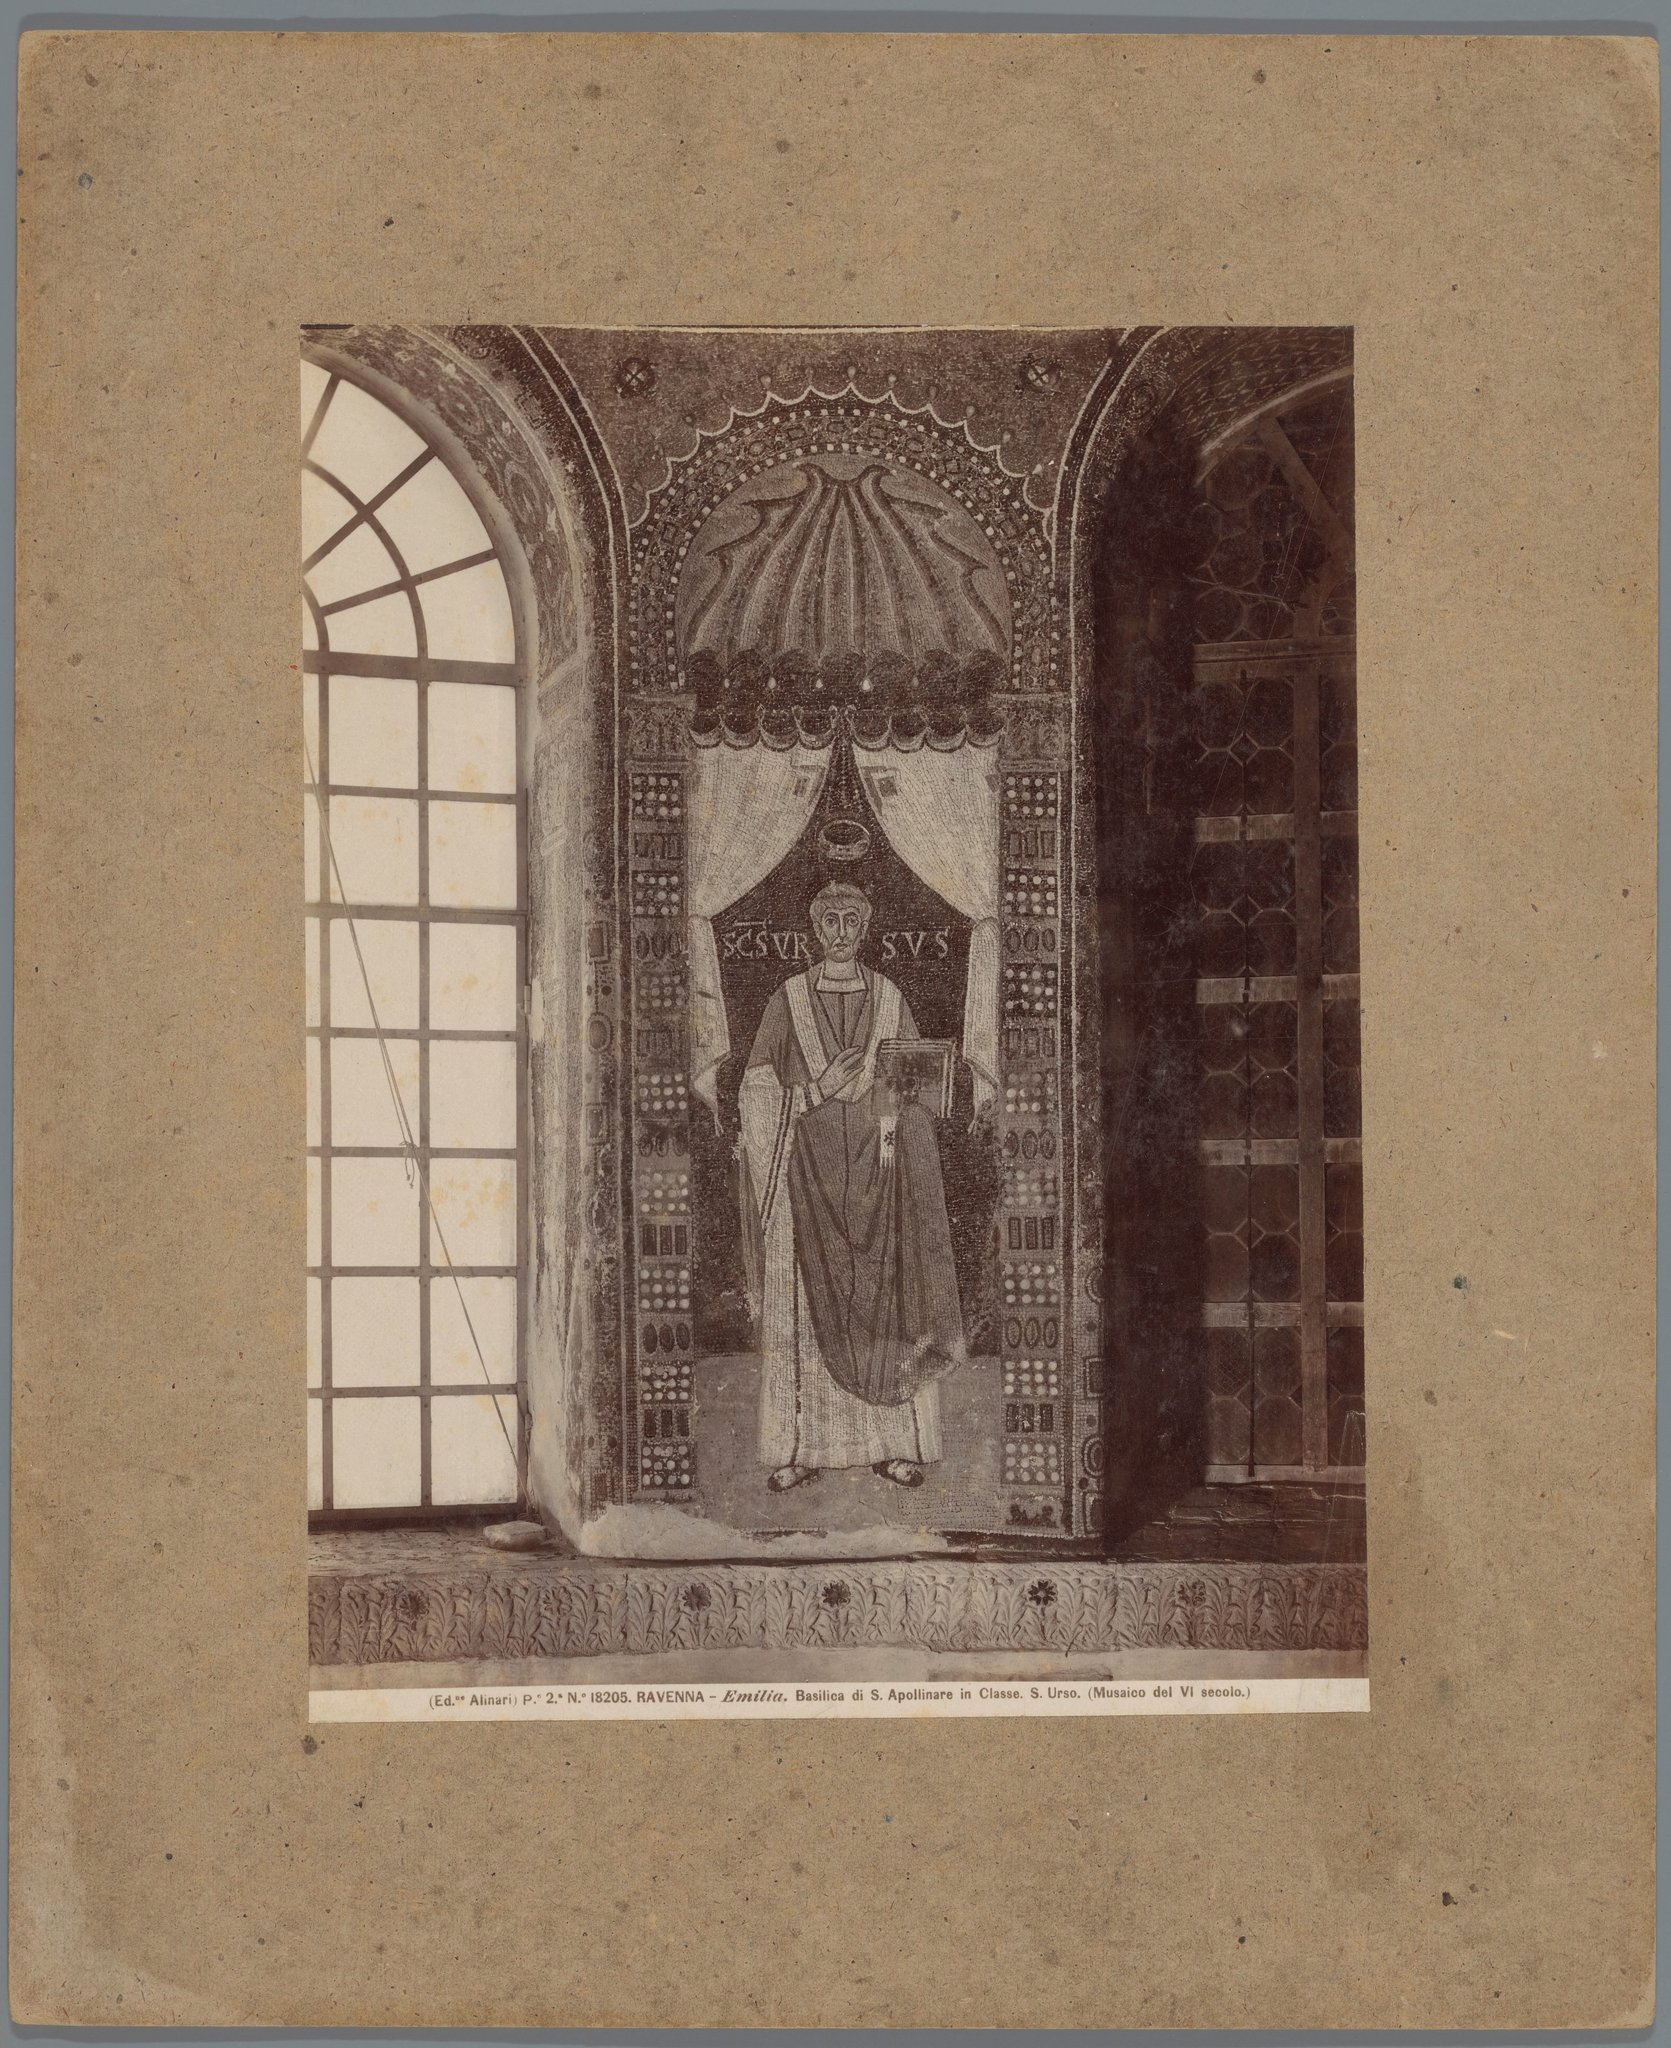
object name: photograph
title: Mozaïek in de Basiliek van Sant'Apollinare in Classe te Ravenna, voorstellende de heilige Ursus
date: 1875-1900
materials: cardboard, photographic support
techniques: albumen print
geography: basiliek van sant'apollinare in classe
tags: art (+ mosaic making), saints, interior of church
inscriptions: collector's mark: Lugt 3937, number: ‘P.e 2.a N.o 18205.’